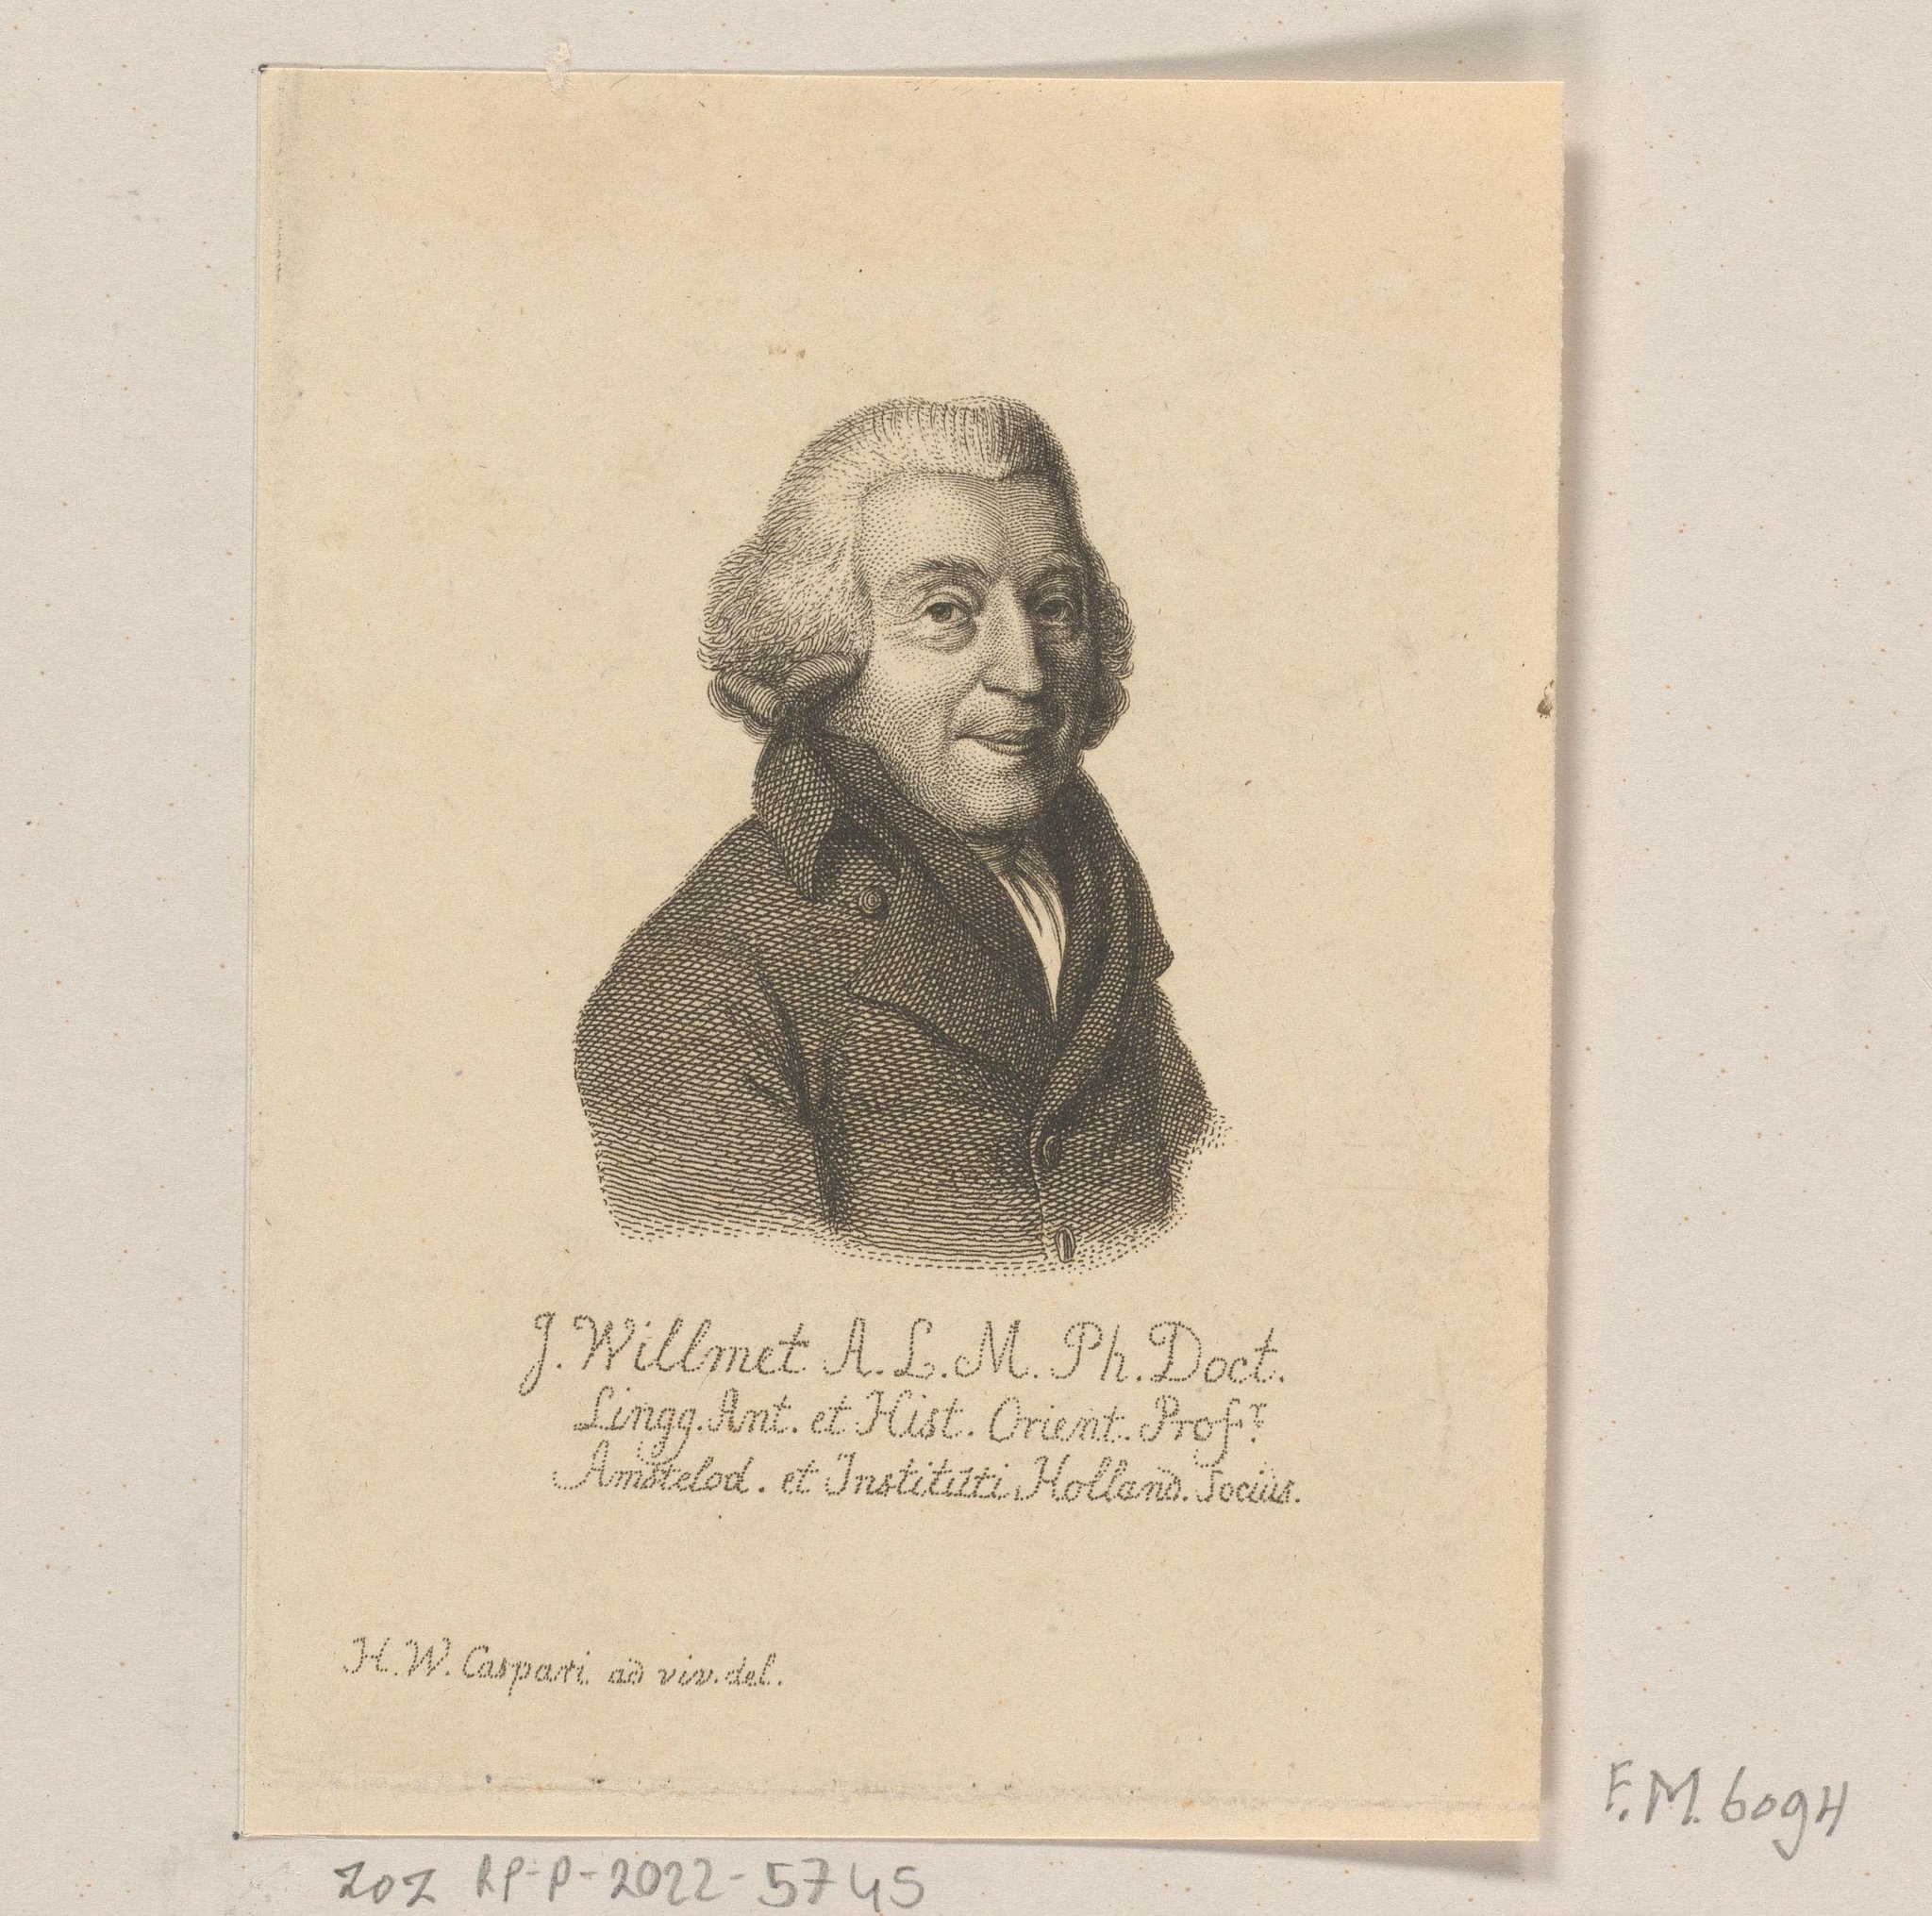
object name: print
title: Studie-prentwerk / Etudes gravées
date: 1804-1815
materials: paper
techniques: engraving, etching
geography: amsterdam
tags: lecture ~ university, historical persons, functionaries and dignitaries ~ protestant churches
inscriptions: inscription: ‘Vroeger/ Herv. Pred. Te/ Loenen/ ob. 1835 eat. 84’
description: De prenten verschenen eerst maandelijks tussen november 1807 en juli 1816. Later gebundeld uitgegeven als: Studie-prentwerk/ Etudes gravées, ca. 1817. In 1834 volgde nog een heruitgave.